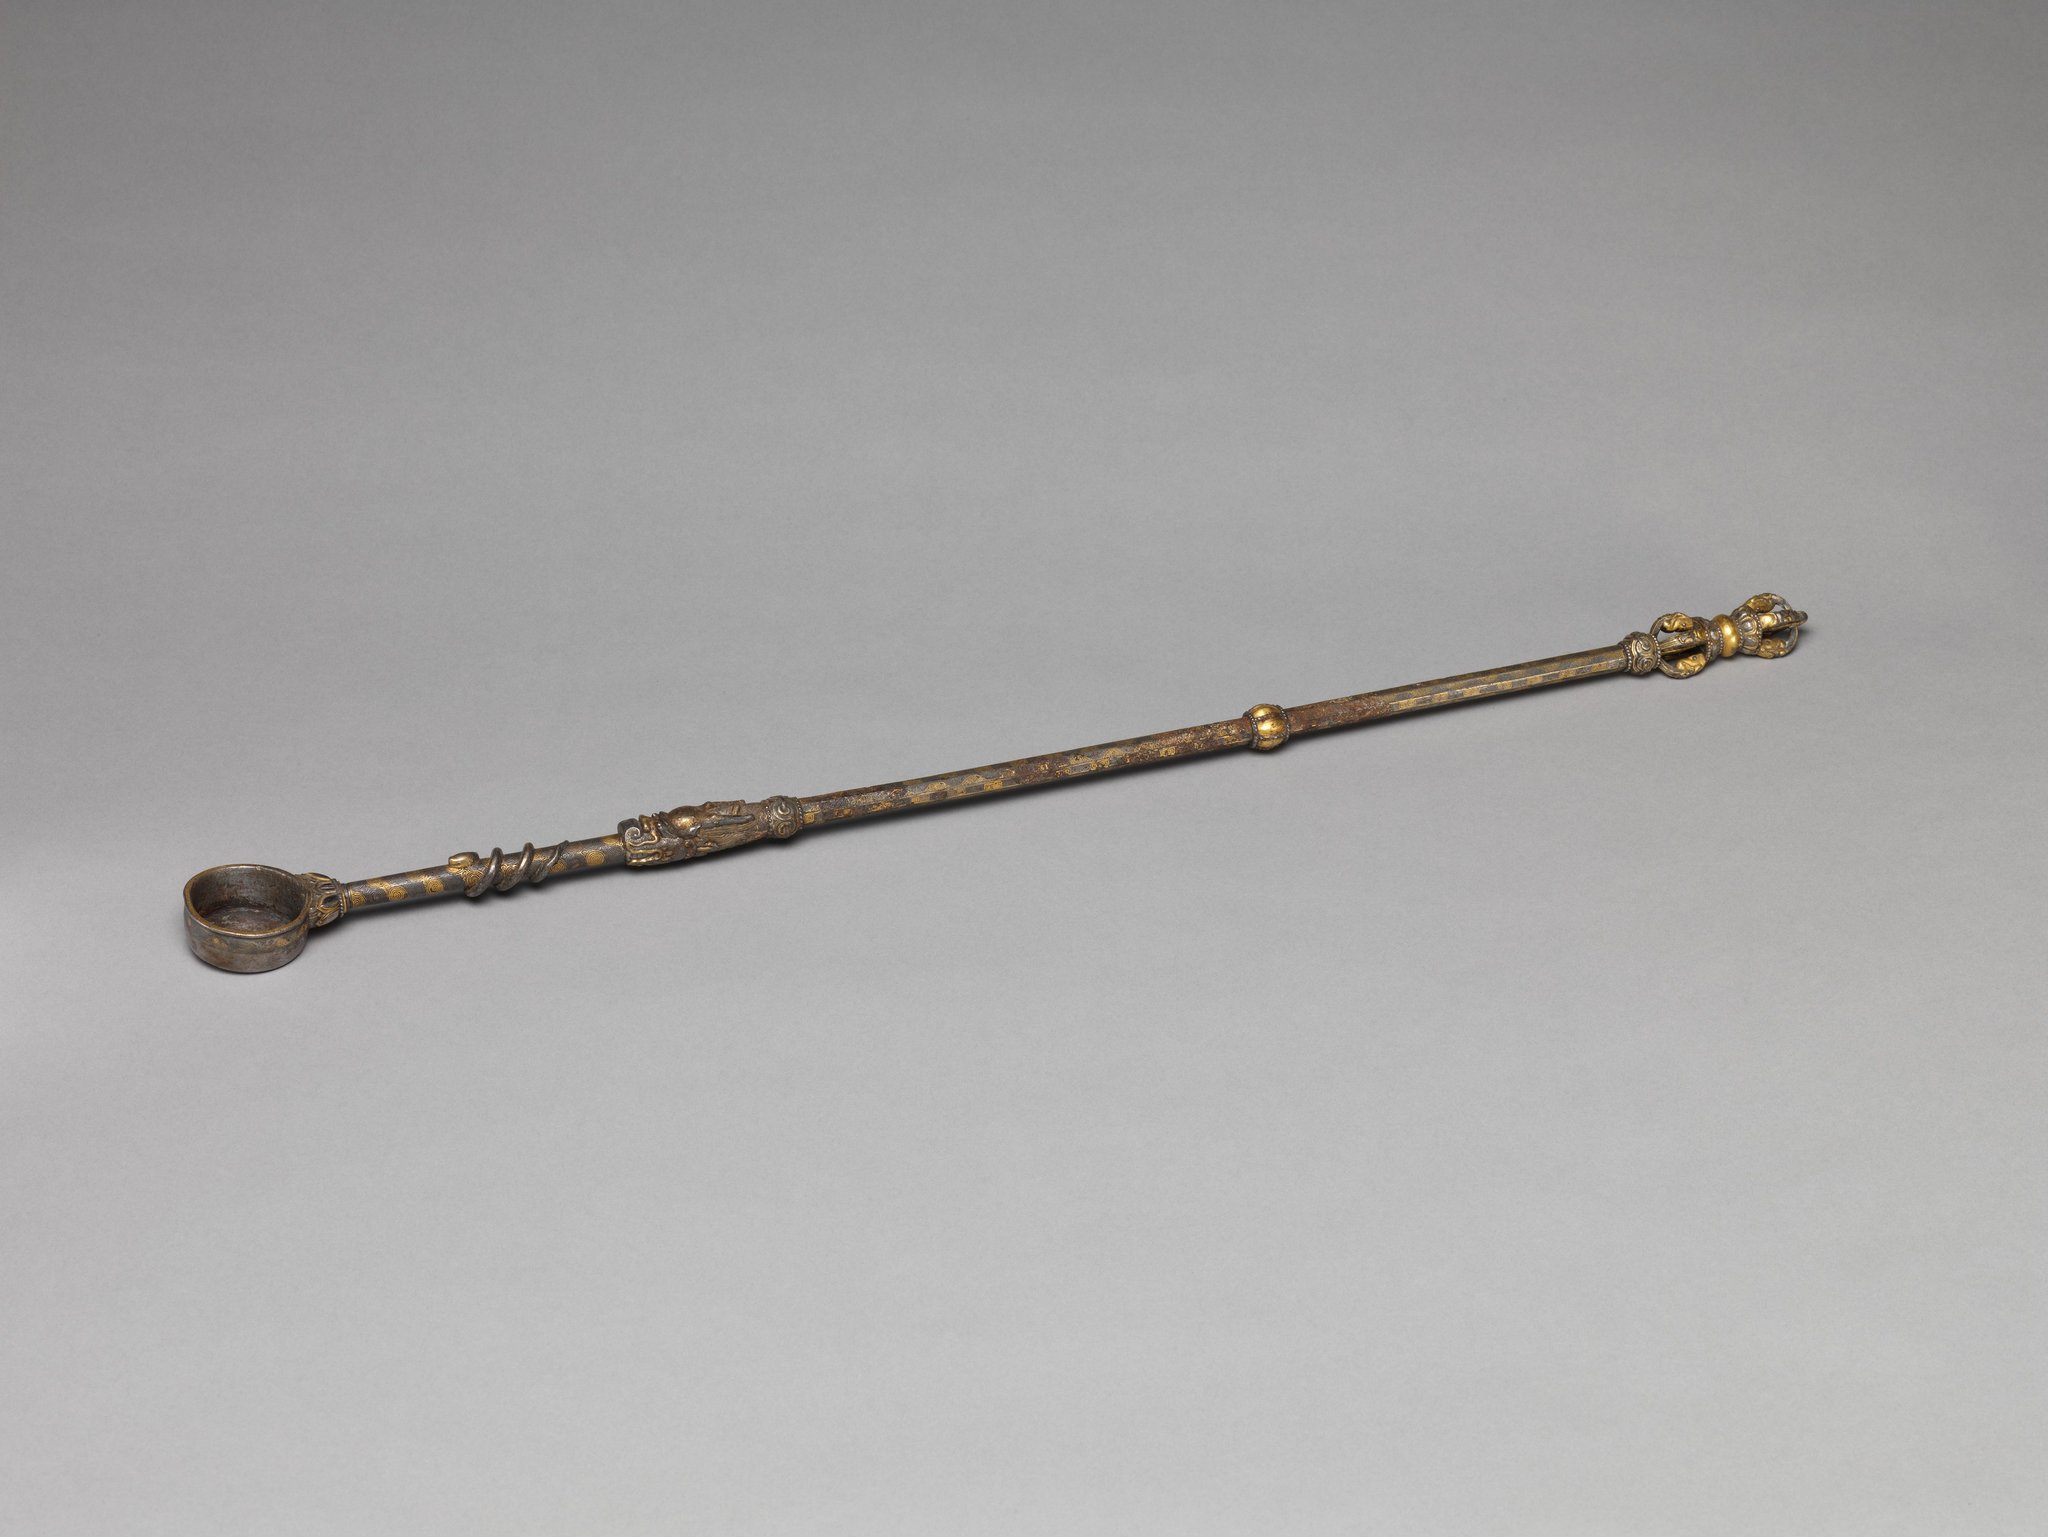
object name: ladle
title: Fire-offering ladle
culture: tibet, eastern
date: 1403-1424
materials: gold, iron, silver